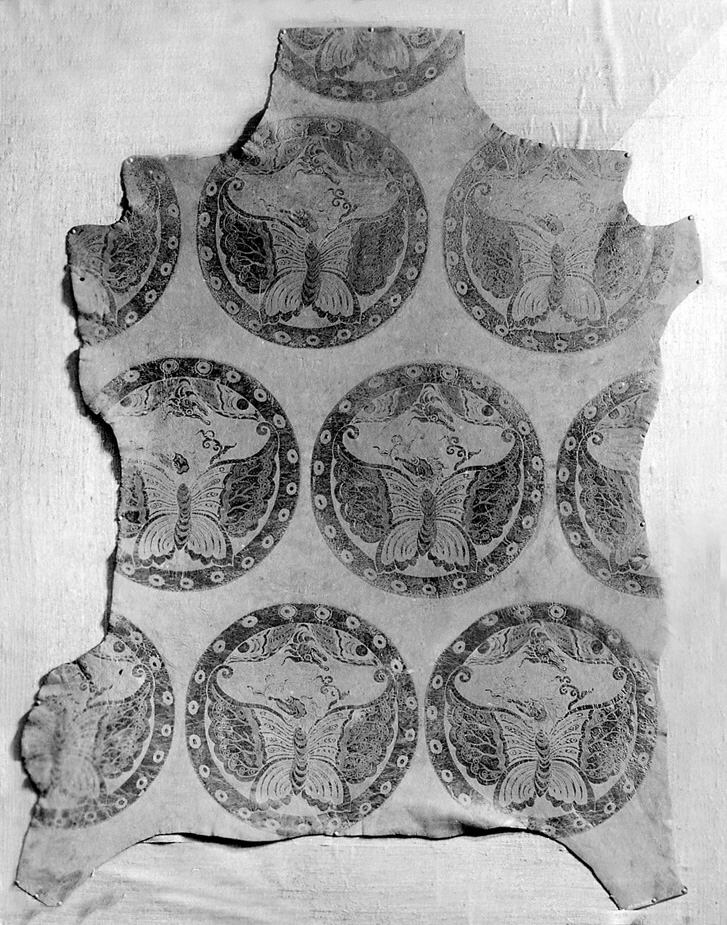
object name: panel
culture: japanese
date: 1801-1900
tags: butterflies